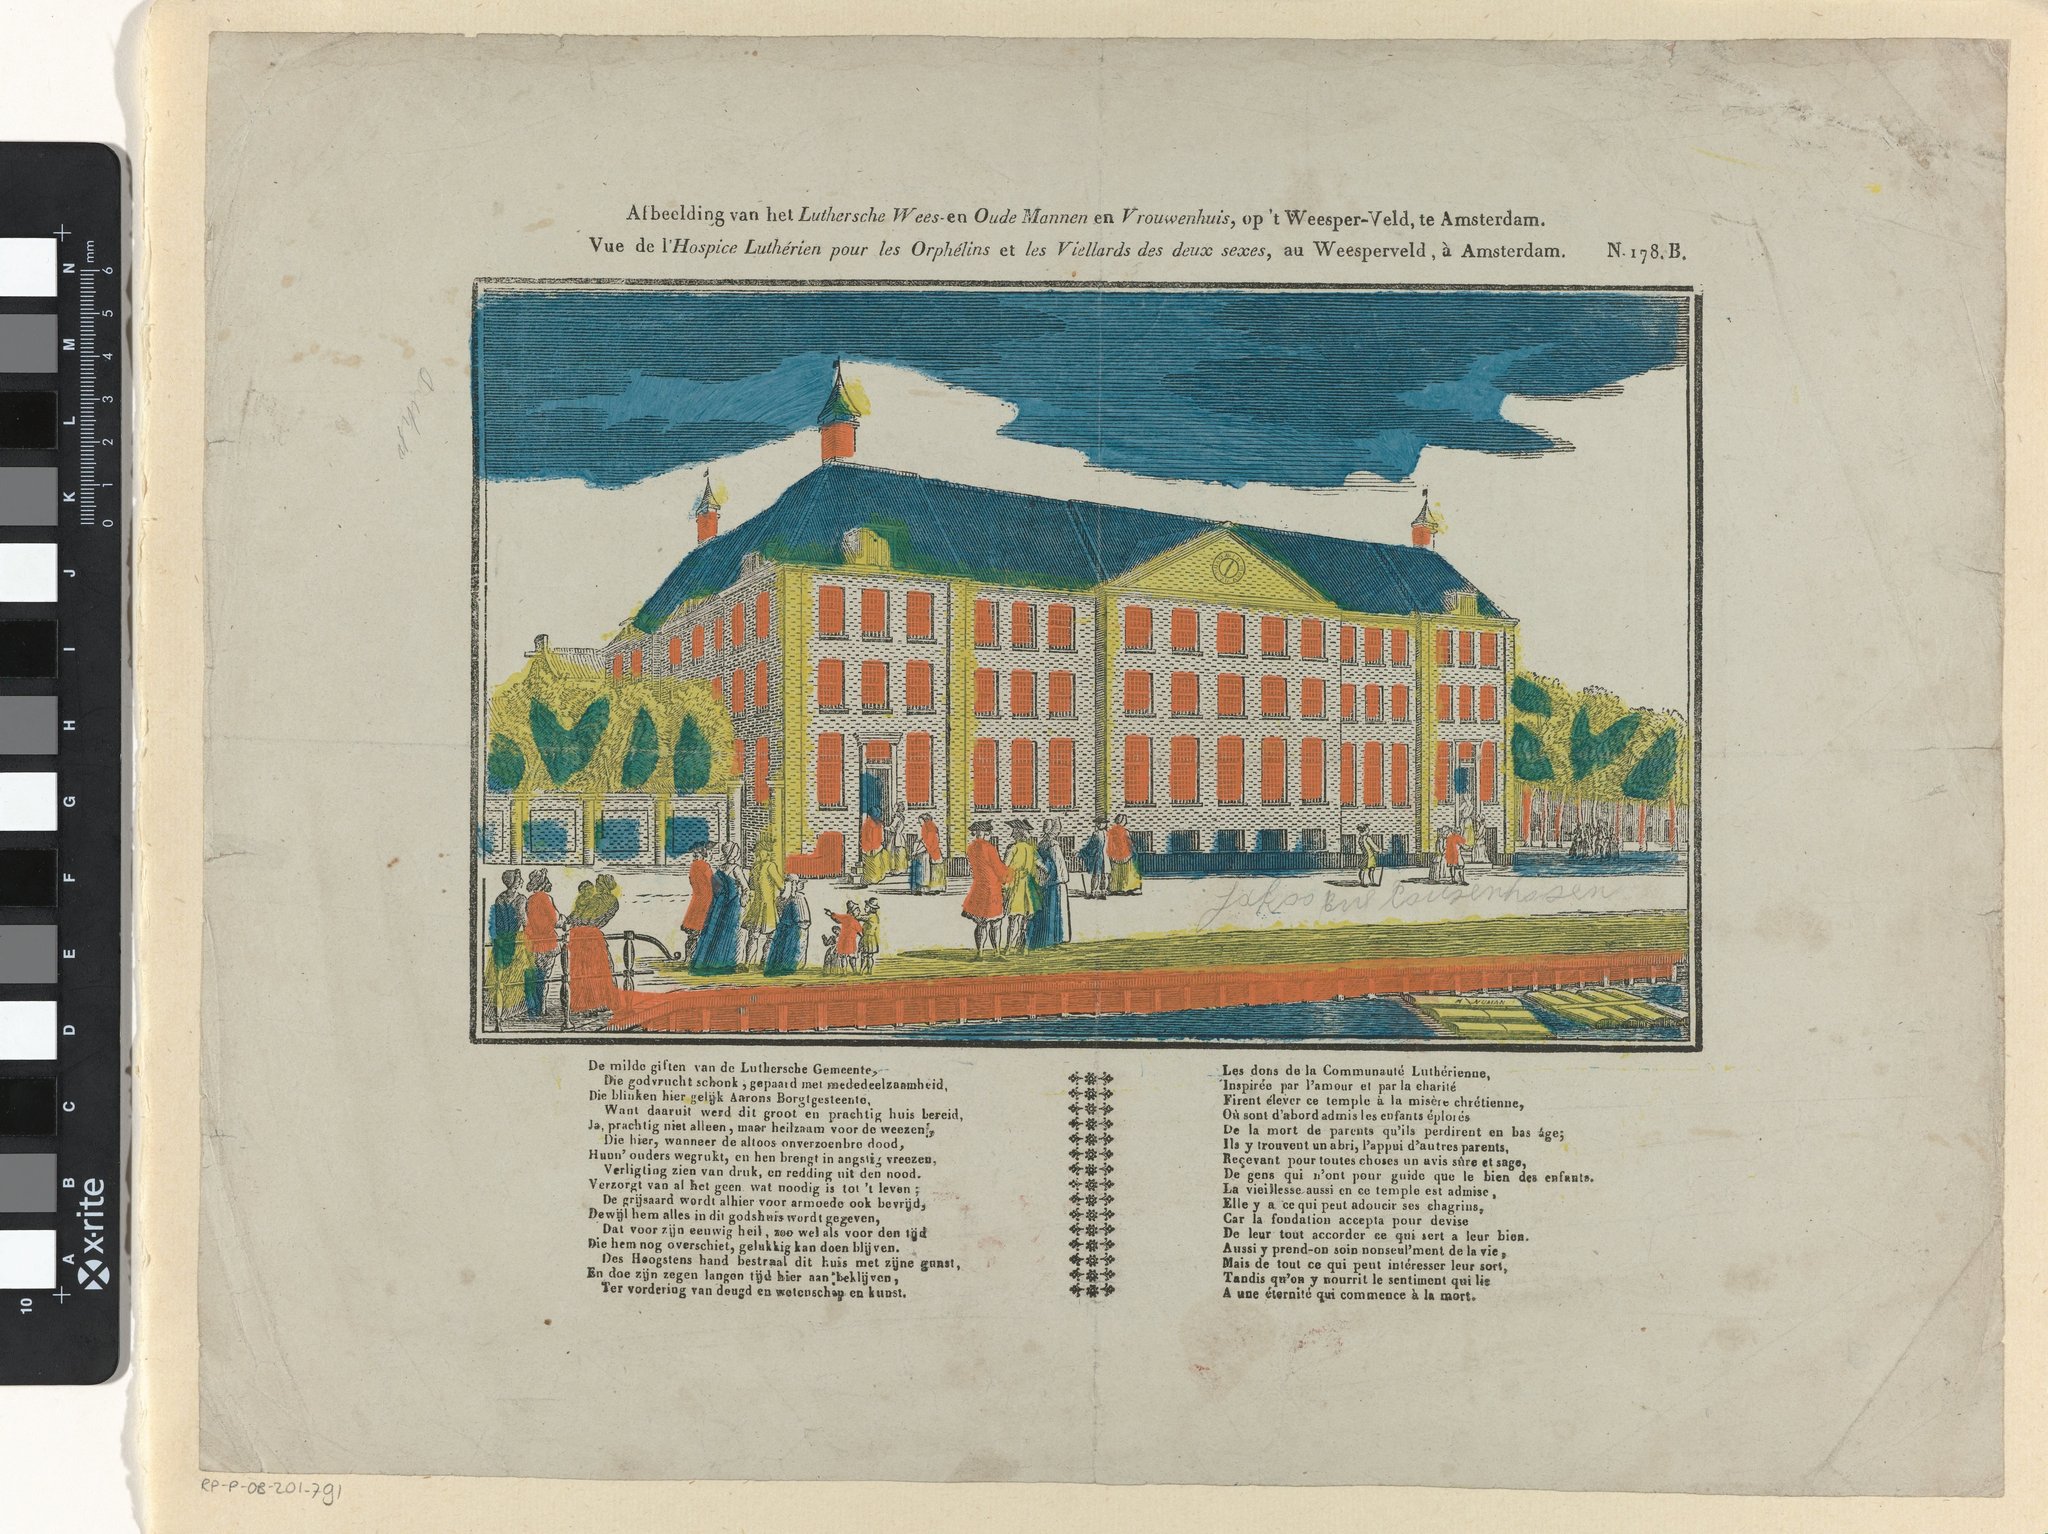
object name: popular print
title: Afbeelding van het Luthersche Wees- en Oude Mannen en Vrouwenhuis, op 't Weesper-veld, te Amsterdam / Vue de l'Hospice Luthérien pour les Orphélins et les Viellards des deux sexes, au Weesperveld, à Amsterdam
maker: philippus jacobus brepols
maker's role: printer, publisher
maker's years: 1778-1845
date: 1800-1833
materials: paper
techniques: colour, letterpress printing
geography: turnhout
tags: orphanage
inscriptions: collector's mark: Lugt 2760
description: Blad met grote voorstelling van het Lutherse Diaconiehuis op 't Weesperveld te Amsterdam. Onder de voorstelling een onderschrift in het Nederlands en in het Frans in twee kolommen. Genummerd rechtsboven: N. 178. B.